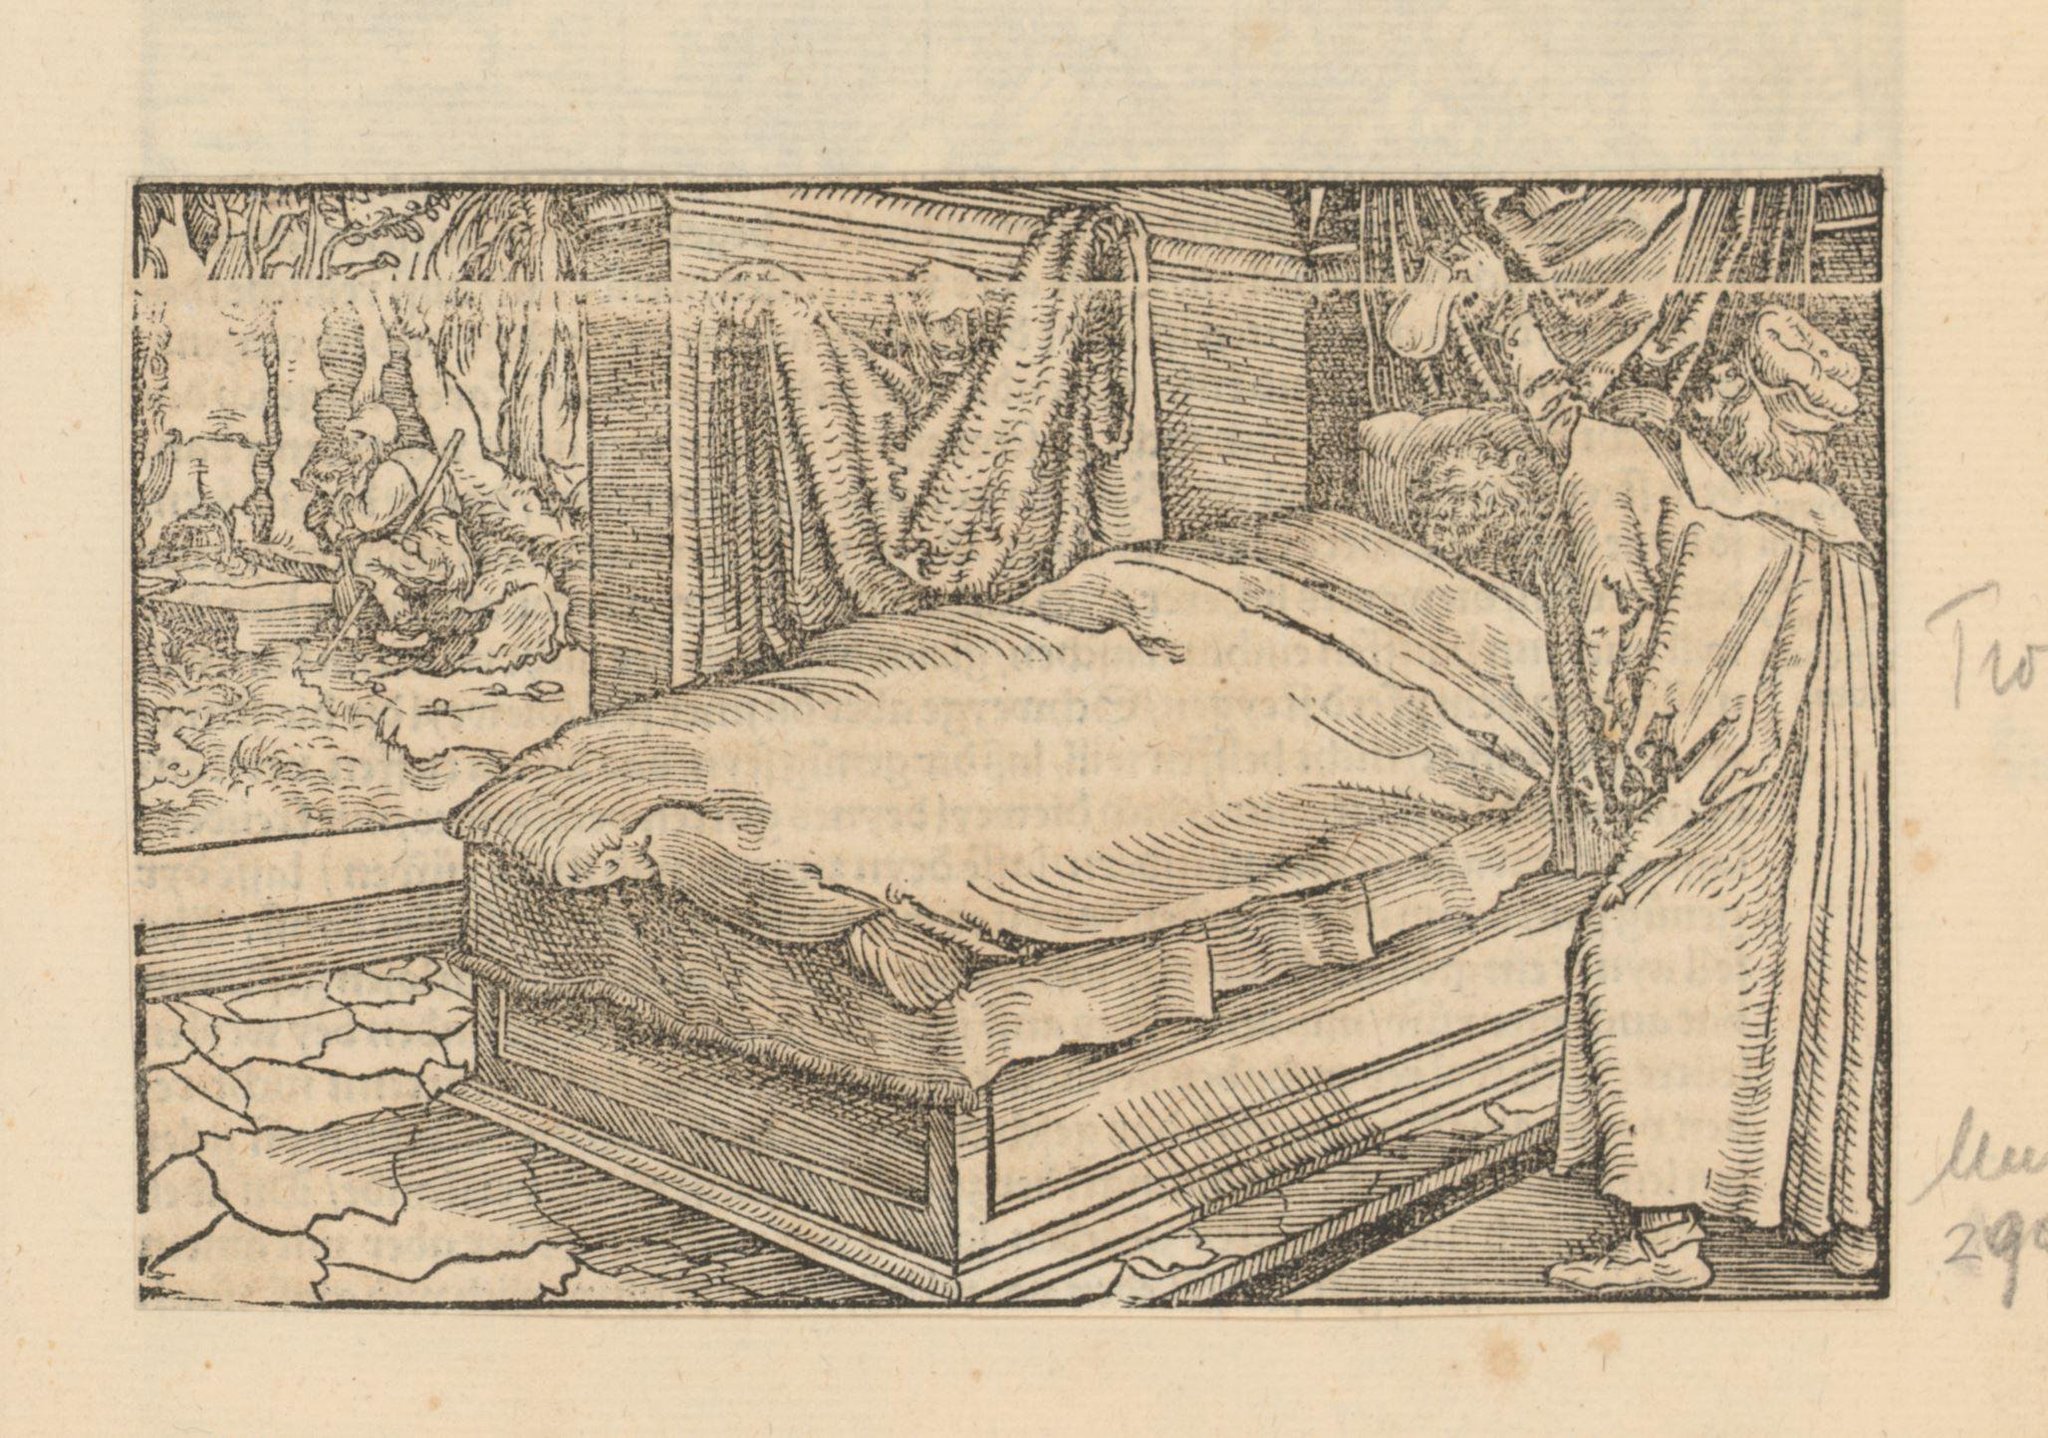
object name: book illustration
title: Dokter controleert urine terwijl een vrouw een extra deken over een zieke legt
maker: Anonymous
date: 1514-1532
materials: paper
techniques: letterpress printing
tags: examination of urine, nursing, tending the sick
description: Deze prent is gebruikt in: Petrarca, Francesco. Von der Artzney bayder Glück, des guten und widerwertigen: unnd weß sich ain yeder inn Gelück und Unglück halten sol (...). Augsburg: Heinrich Steiner, 1532. Deze uitgave is ook bekend onder de titel 'Trostspiegel in Glück und Unglück'.